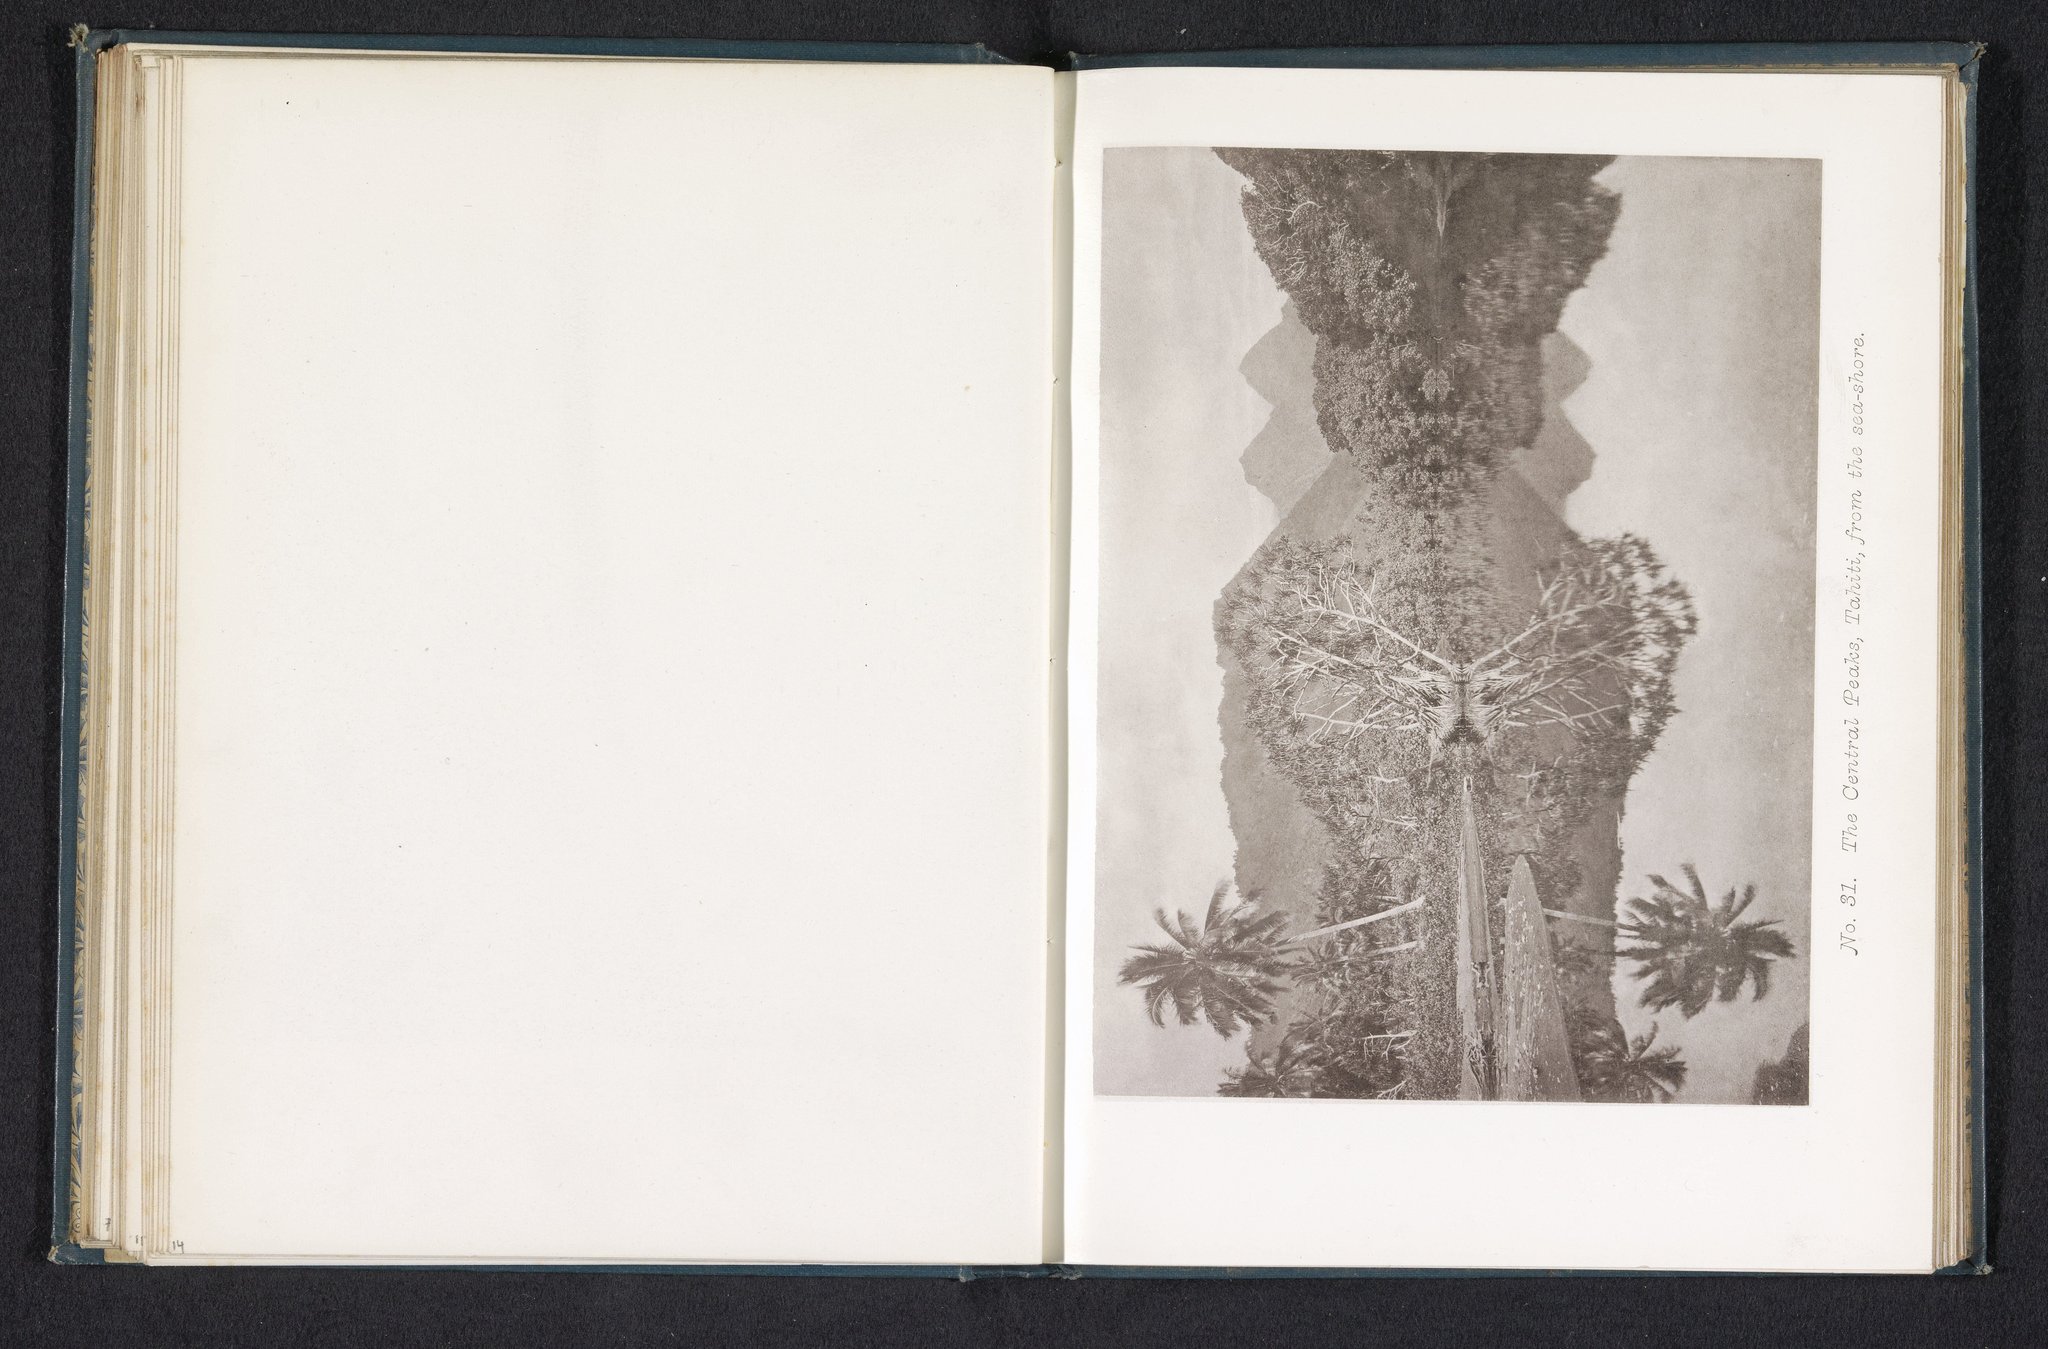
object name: photomechanical print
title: Gezicht op de bergen op Tahiti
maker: henry stuart-wortley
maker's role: fotograaf, kolonel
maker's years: 1832-1890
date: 1880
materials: paper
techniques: photograph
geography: tahiti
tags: trees: palm-tree, mountains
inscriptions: number: ‘No. 31.’